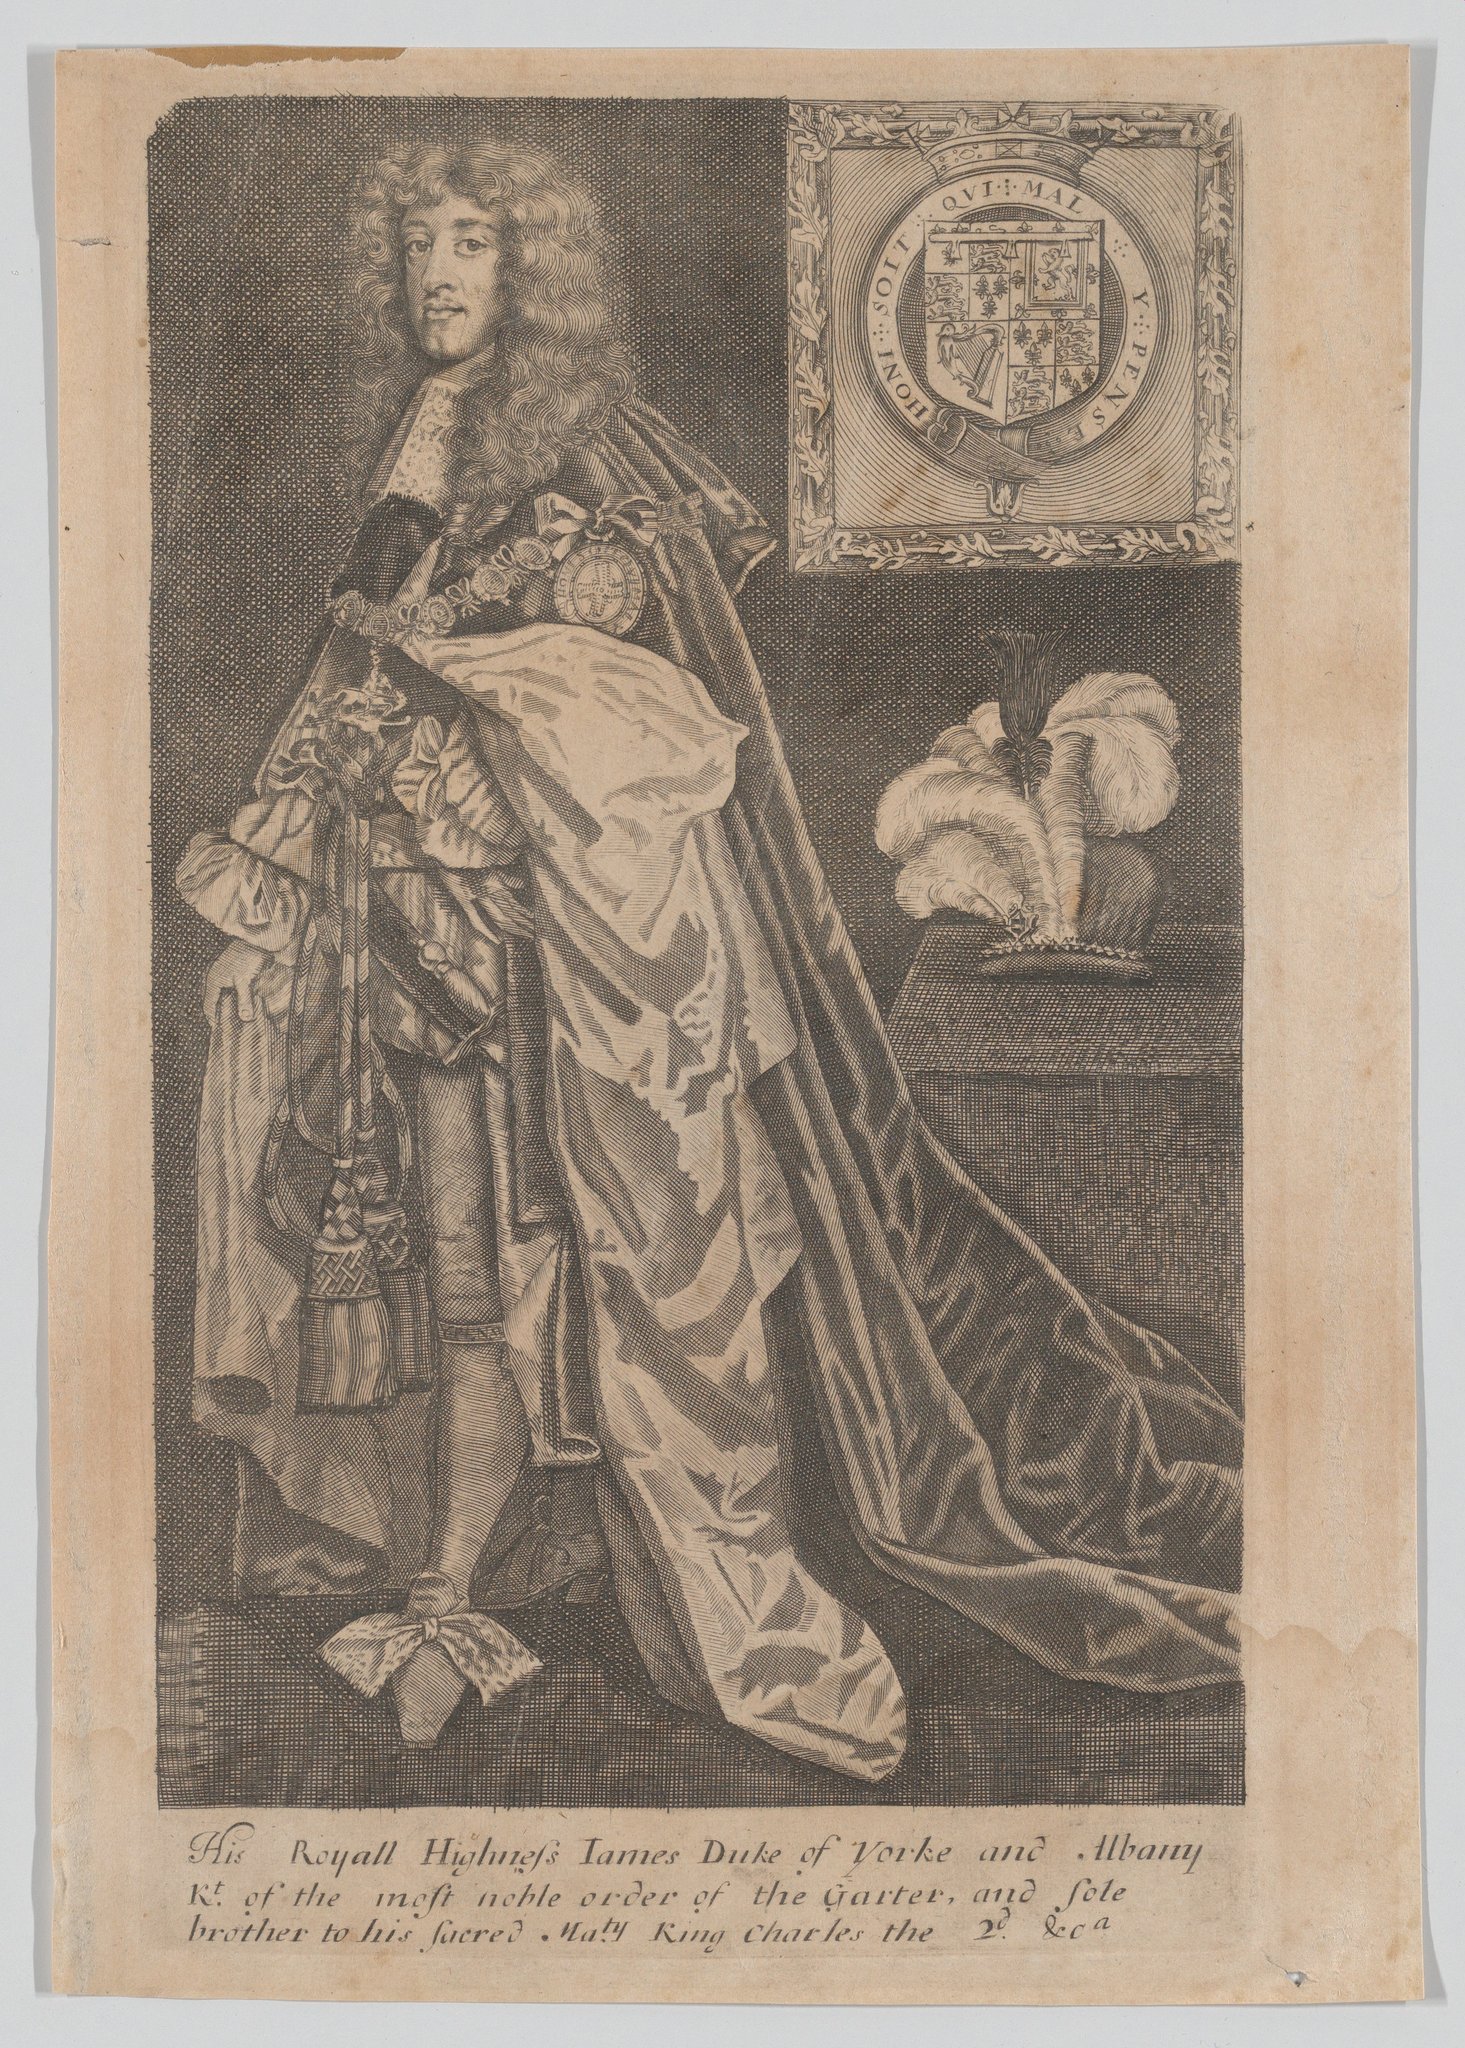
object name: print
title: His Royal Highness James Duke of Yorke and Albany, Knight of the most noble order of the Garter, and sole brother to his sacred Majesty King CHarles the 2d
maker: anonymous, british, 17th century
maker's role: artist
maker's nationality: british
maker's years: 1600-1700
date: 1680-1685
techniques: engraving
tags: men,portraits,coat of arms